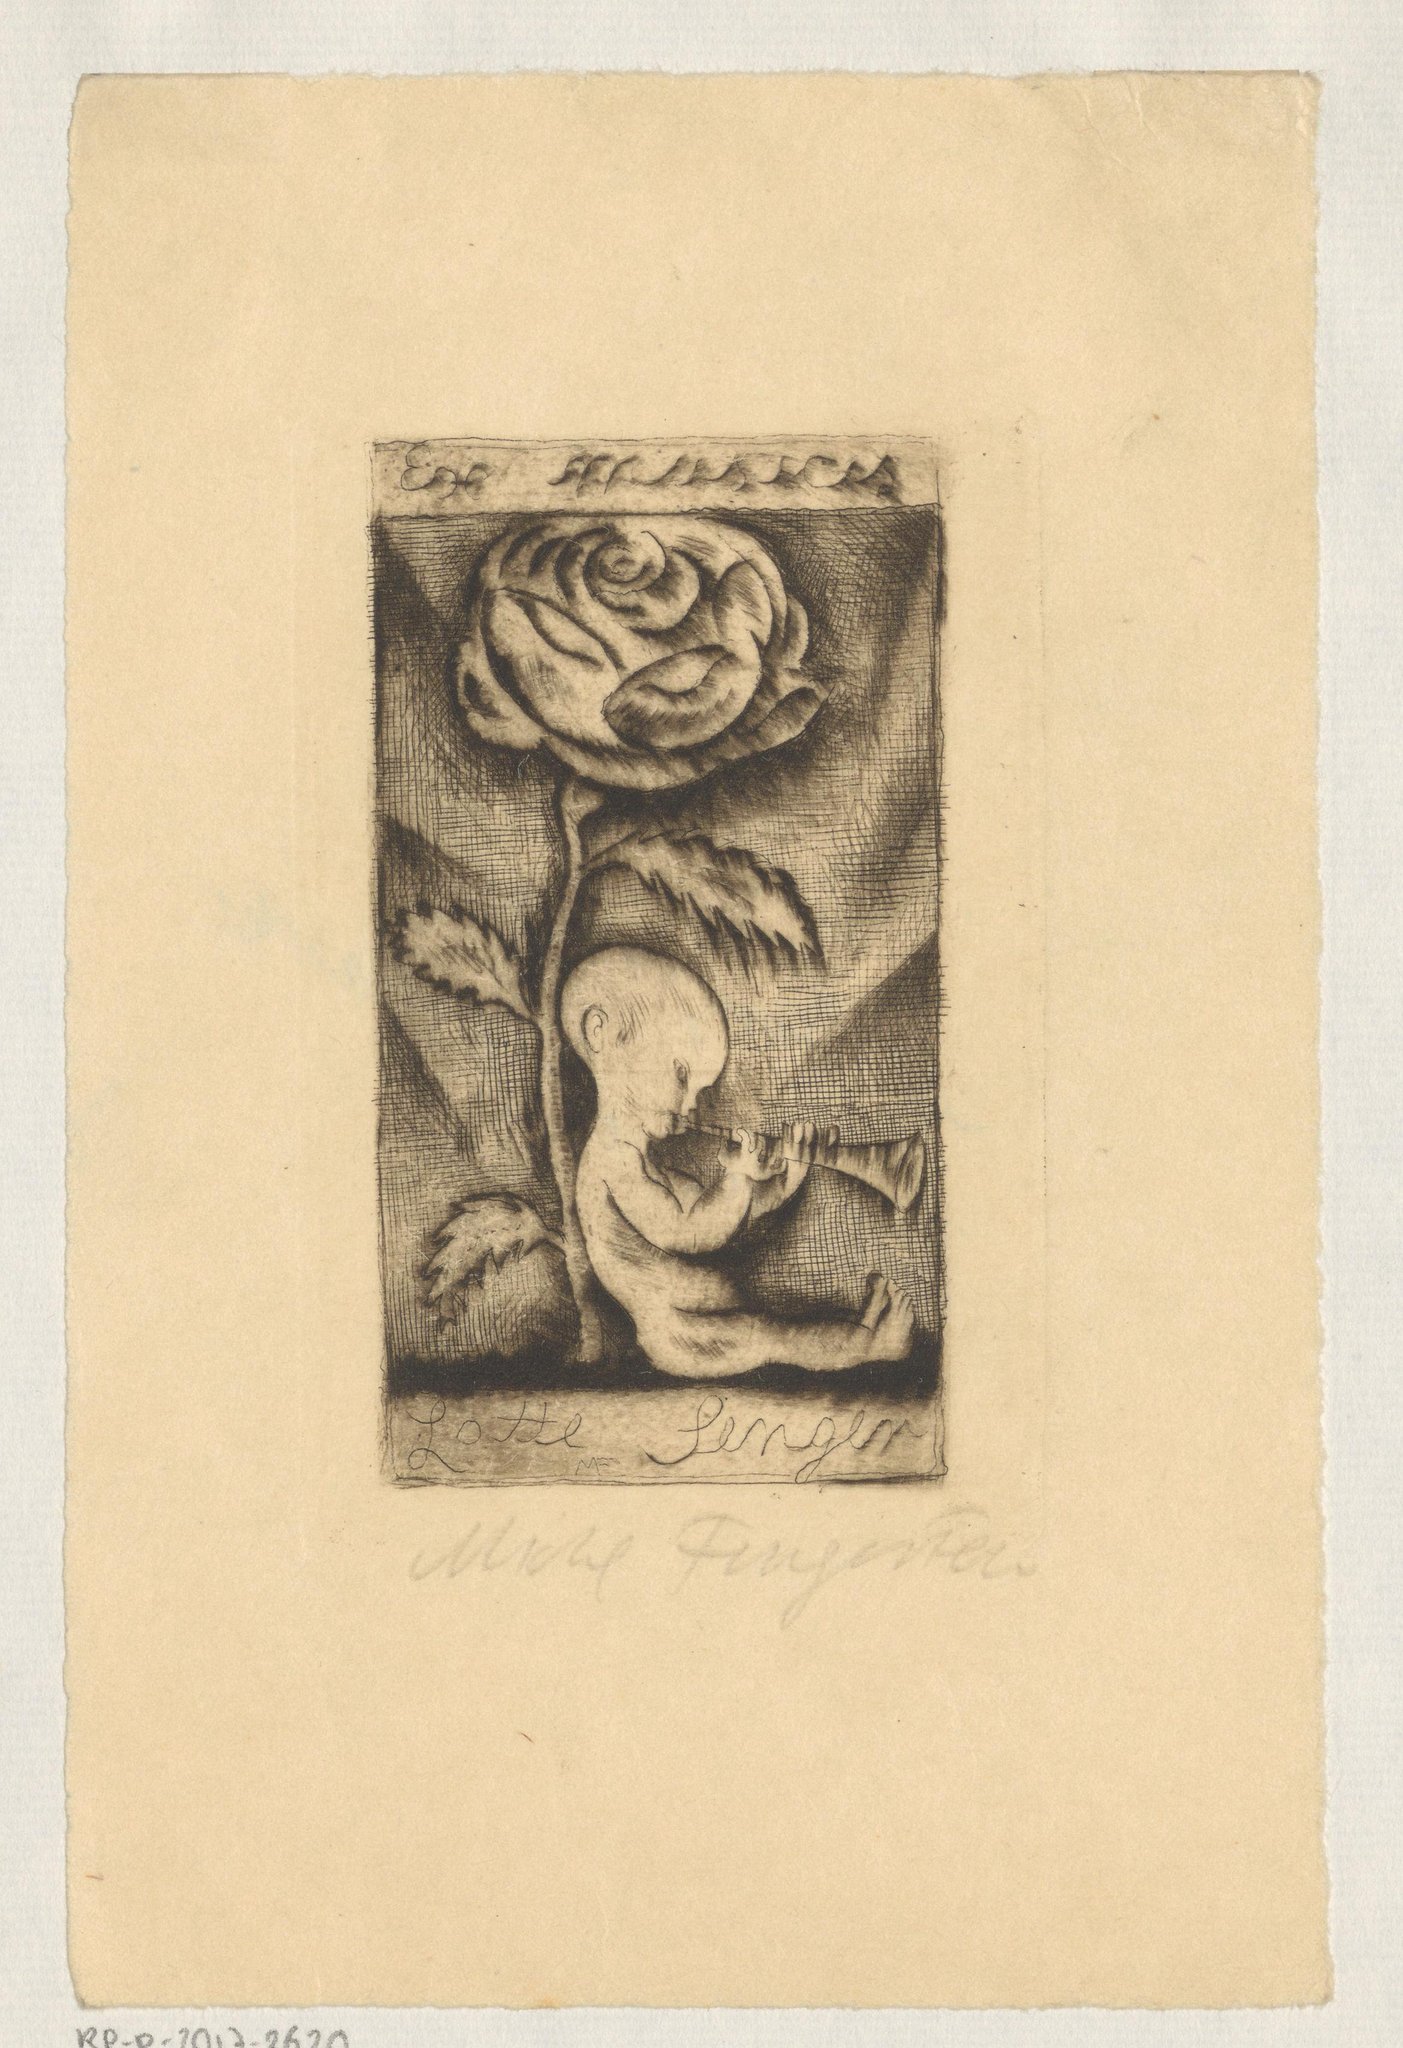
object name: bookplate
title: Ex libris van Lotte Senger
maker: michel fingesten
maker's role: painter, print maker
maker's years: 1884-1943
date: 1894-1943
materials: paper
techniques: drypoint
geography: austria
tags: flowers: rose, infant, baby, flute, aulos, tibia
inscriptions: inscription: ‘M. Fingesten / Tyskl[...] (?) ecl Osterrikt (?)’, signature: ‘Michel Fingesten’